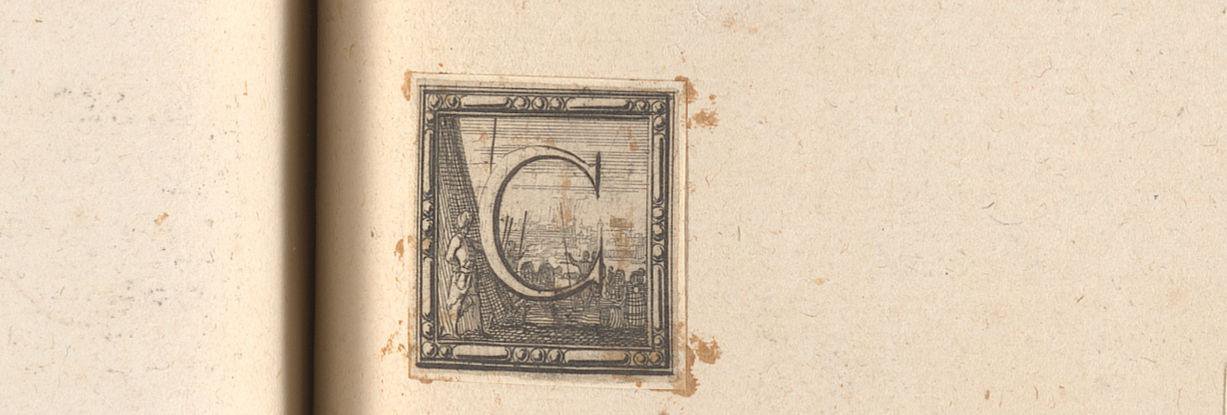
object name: print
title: Initiaal 'C' met een soldaat voor een tent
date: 1670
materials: paper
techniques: etching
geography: paris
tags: (military) camp with tents, vignette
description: Prent gebruikt voor: Rycaut, Paul. Histoire de l'état présent de l'Empire ottoman (...). Parijs: Sébastien Mabre-Cramoisy, 1670.